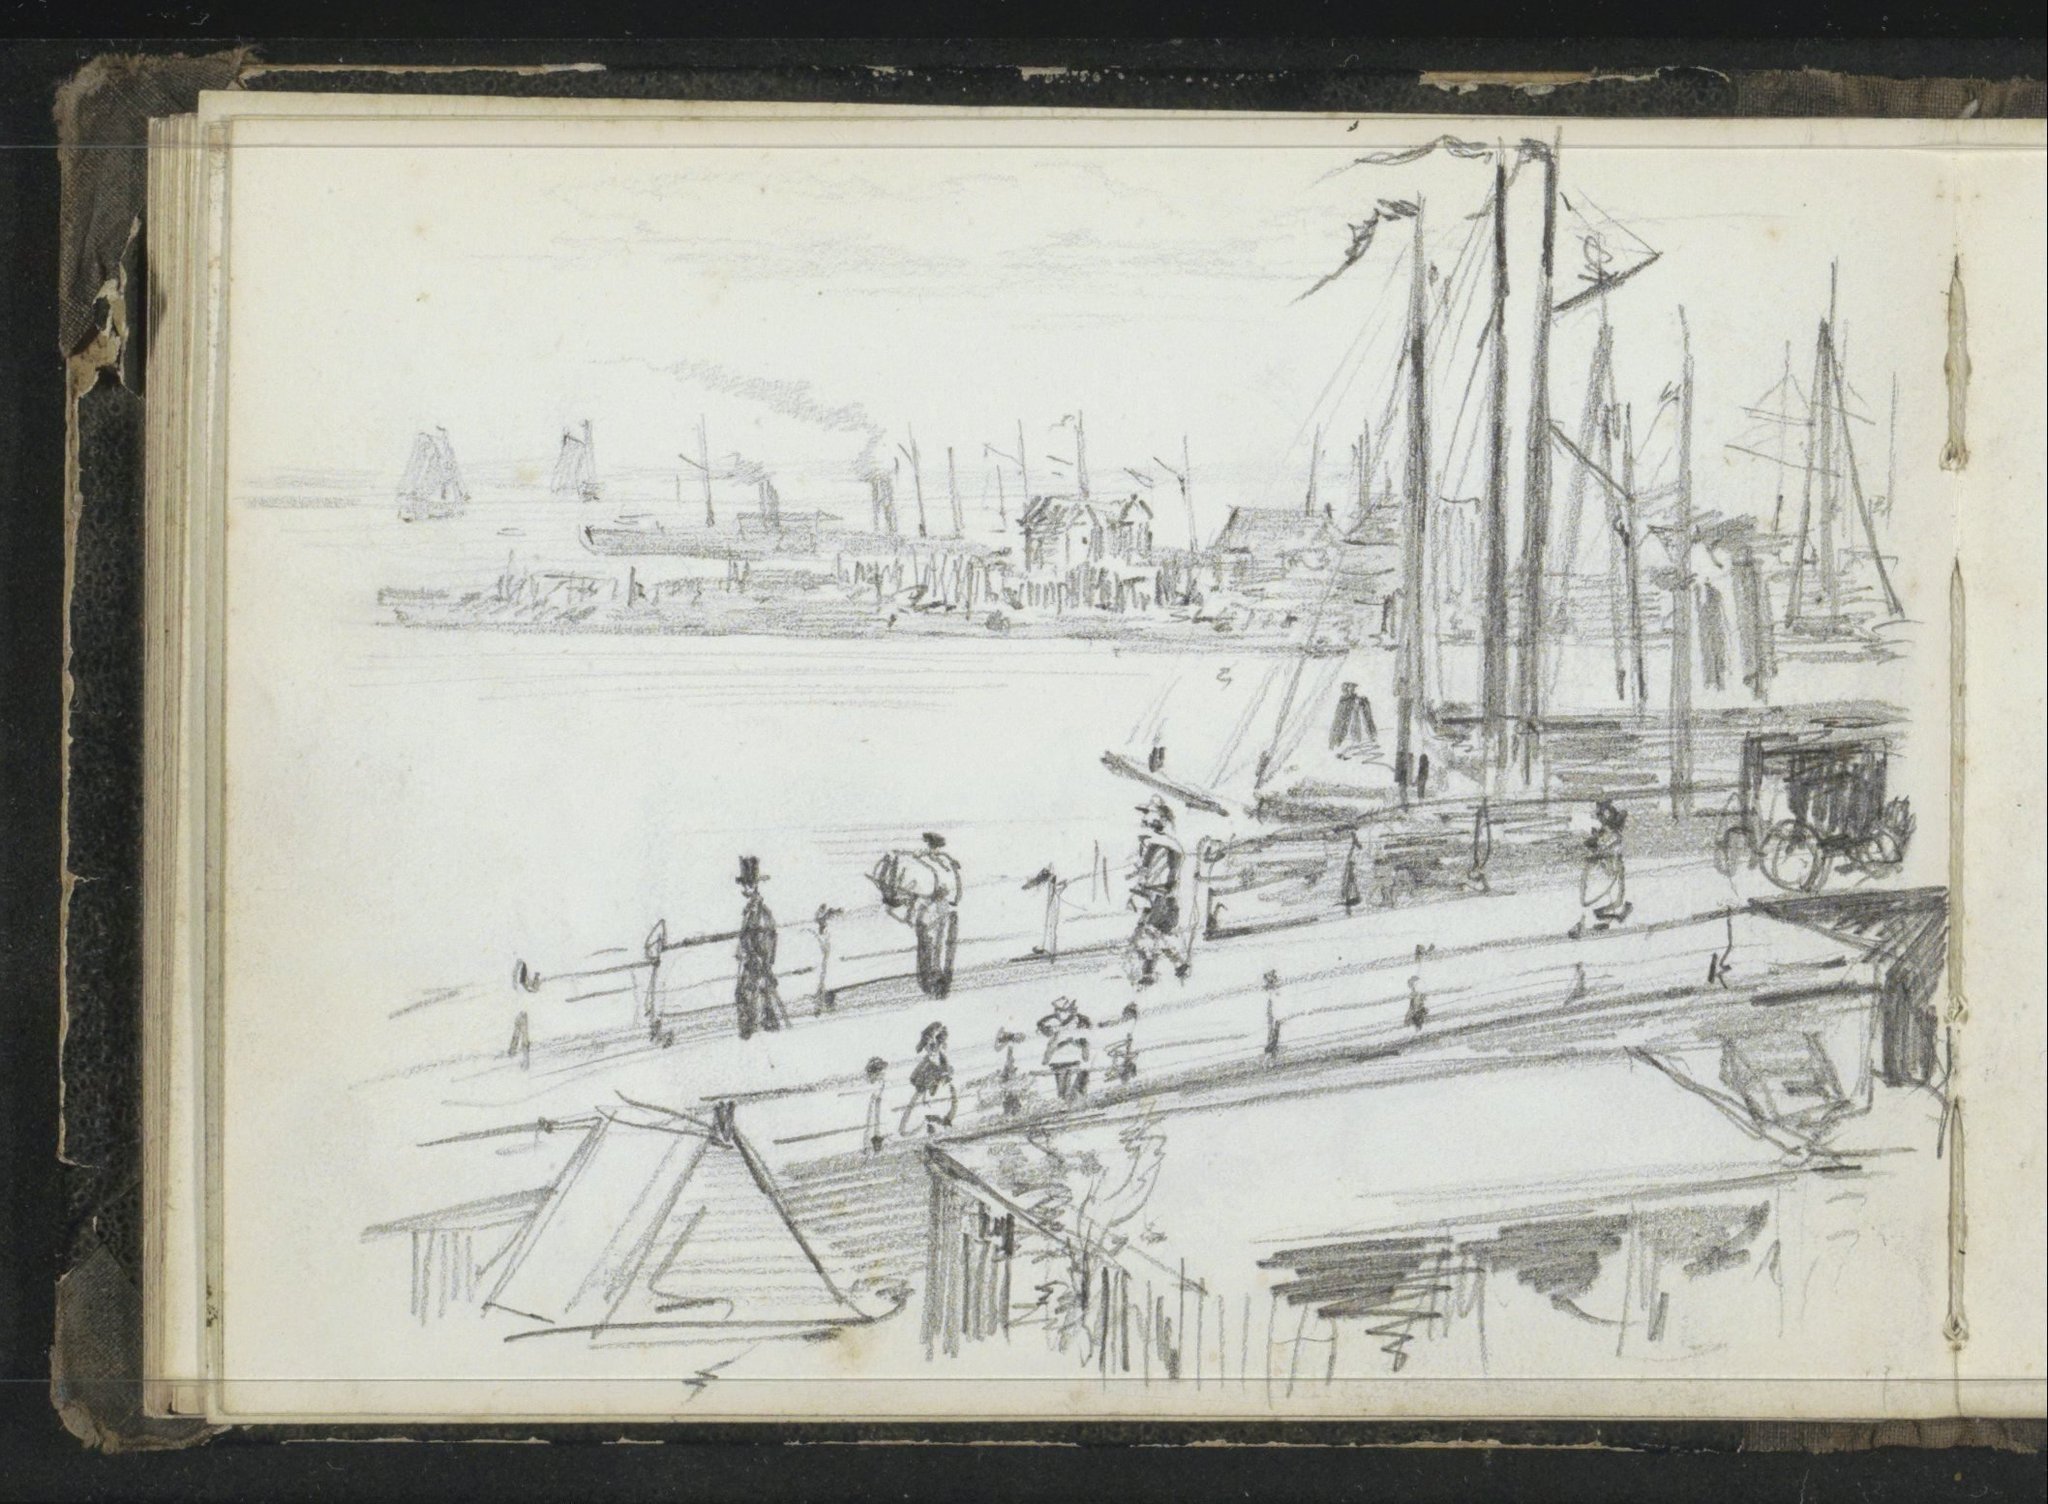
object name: sketchbook leaf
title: Figuren op een boulevard bij een haven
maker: theo hanrath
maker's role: draughtsman, painter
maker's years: 1853-1883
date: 1879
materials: paper, pencil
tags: harbour, avenue, boulevard, promenade, esplanade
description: Blad 19 verso uit een schetsboek met 27 bladen.